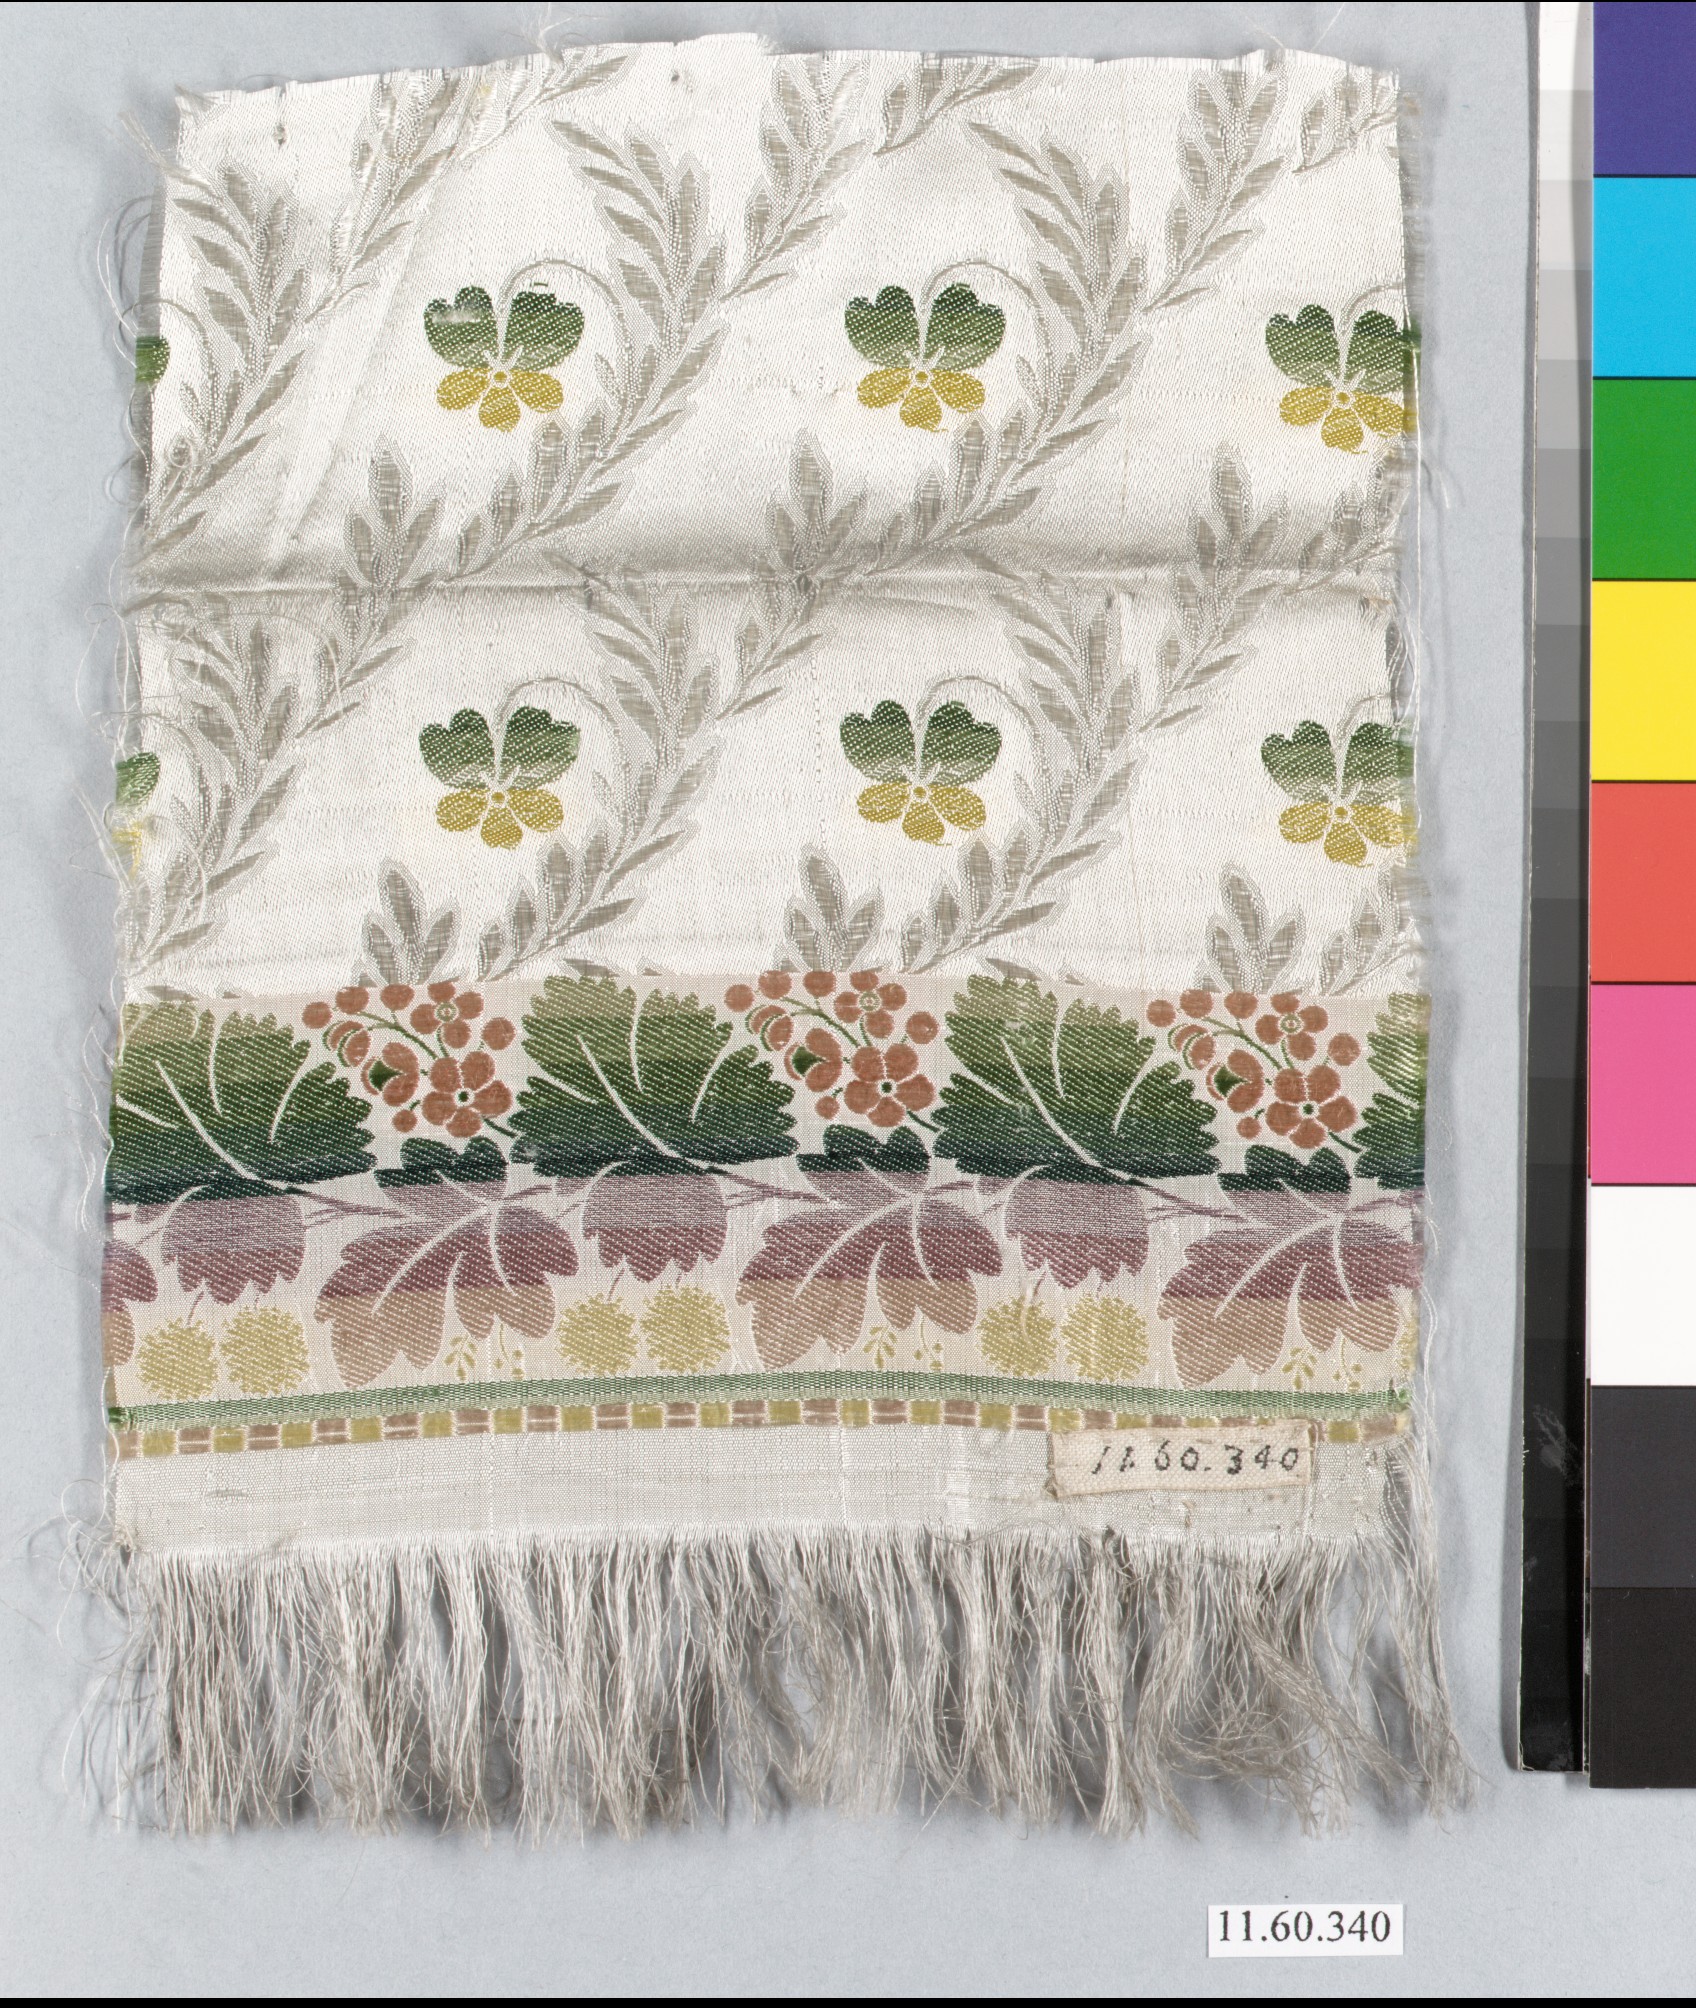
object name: fragment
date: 1801-1900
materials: silk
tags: flowers,leaves